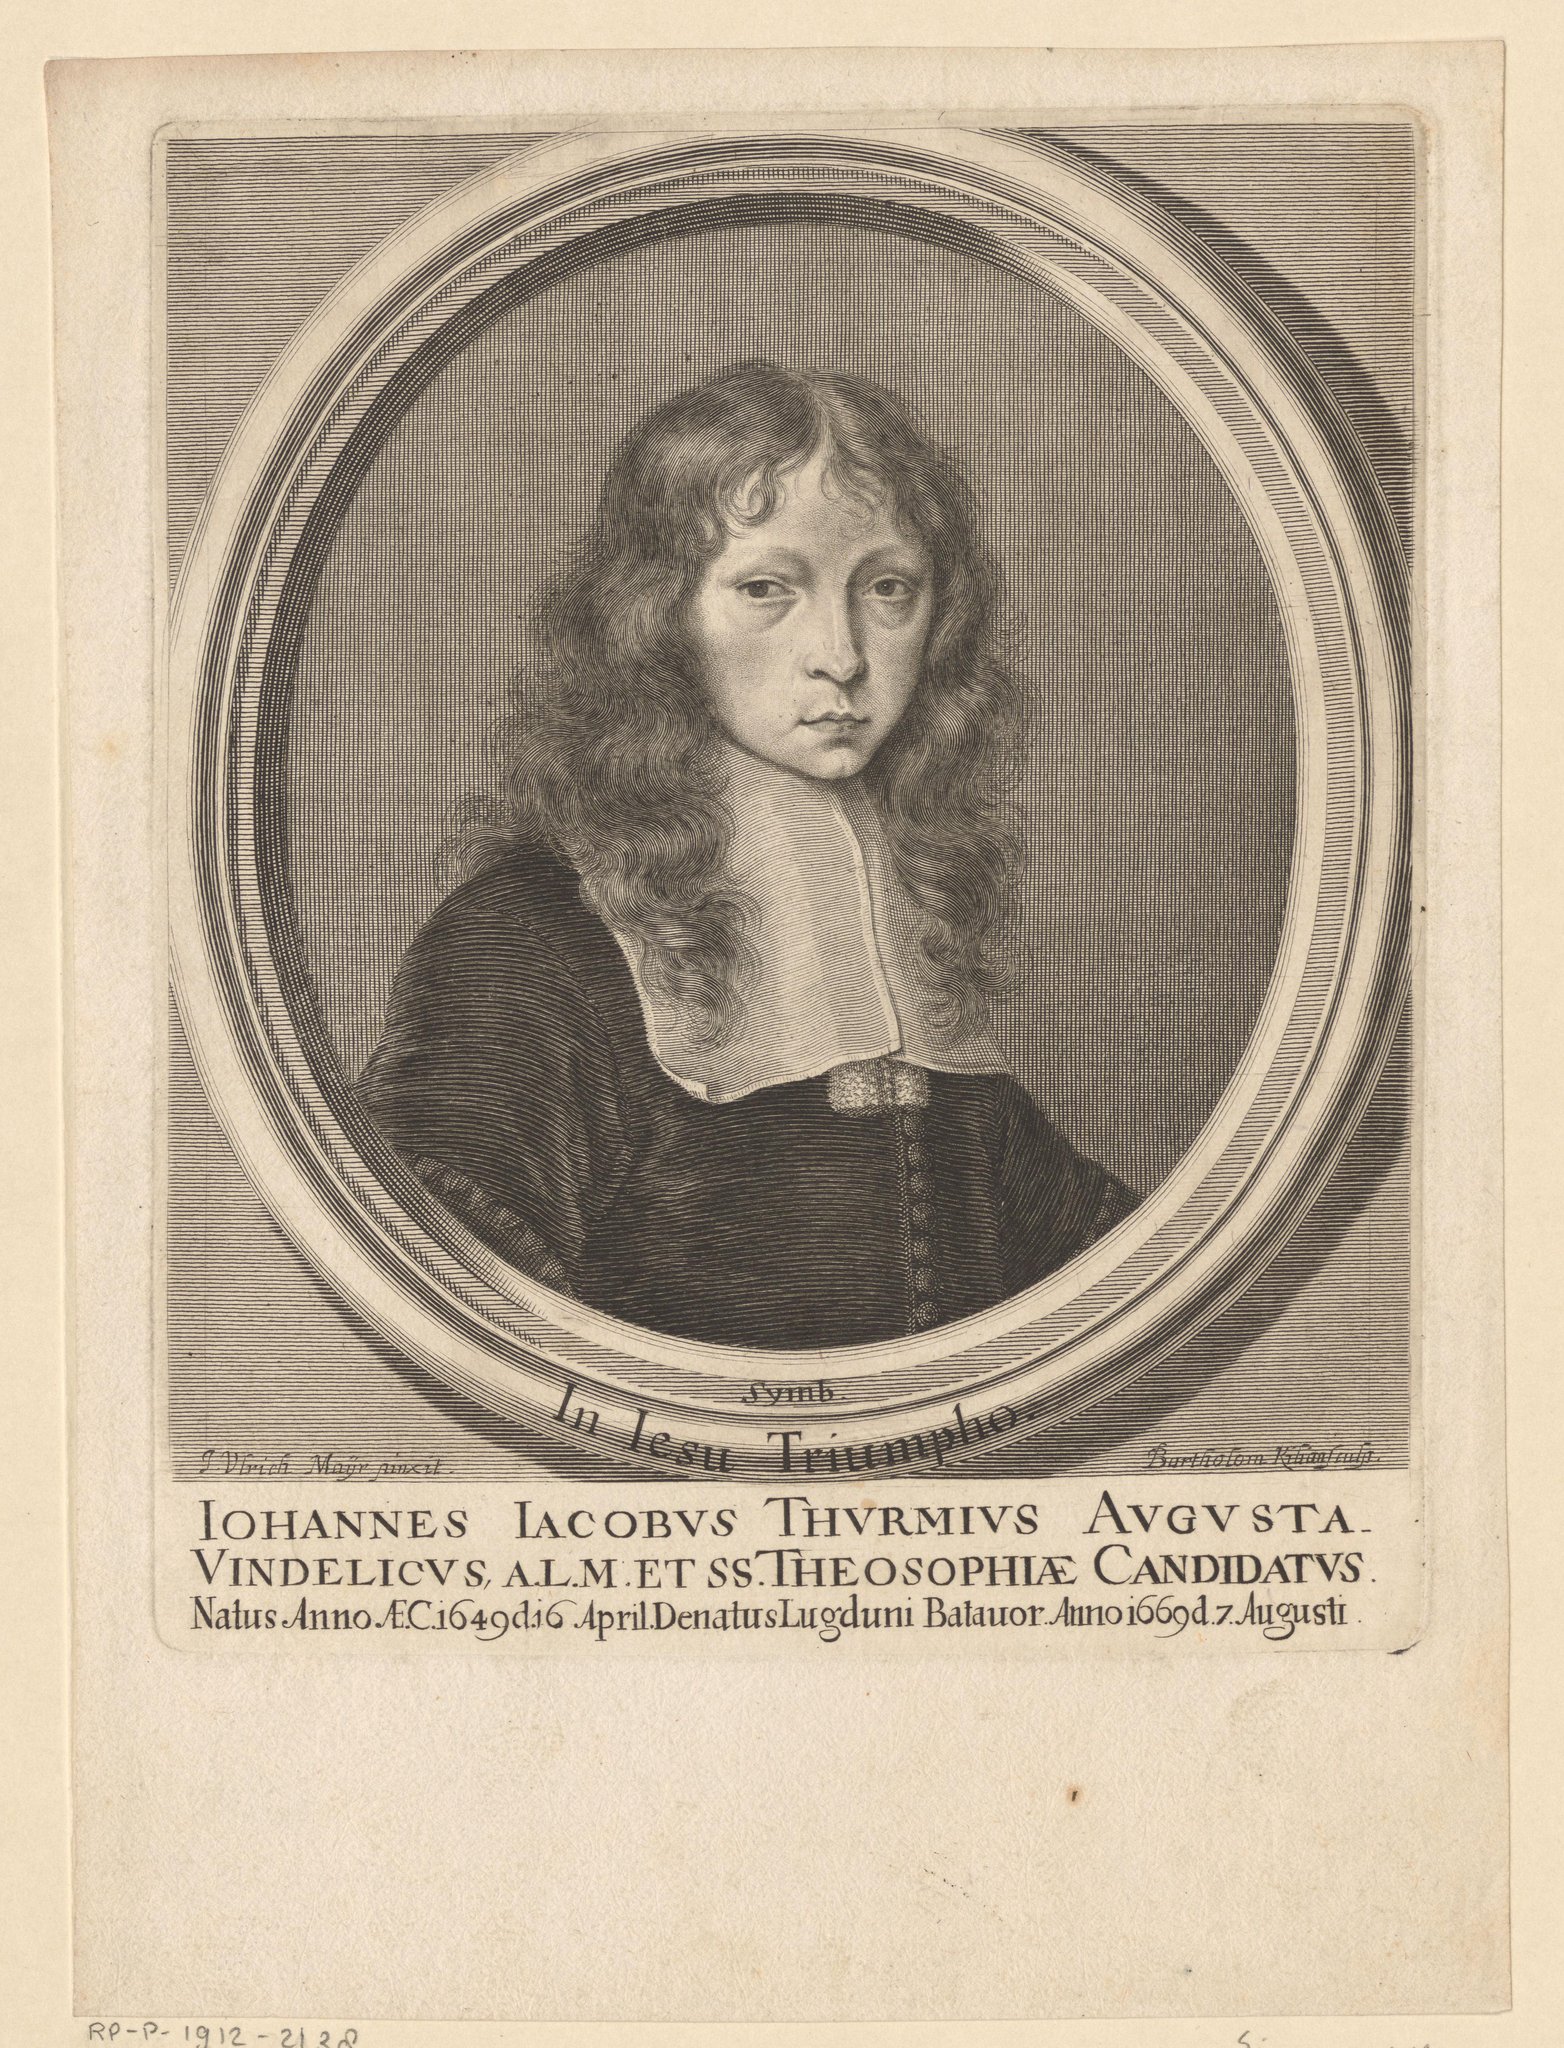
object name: print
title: Portret van Johann Jacob Thurm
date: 1669-1696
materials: paper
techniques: engraving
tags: augsburg, theologian, historical persons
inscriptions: collector's mark: Lugt 2228